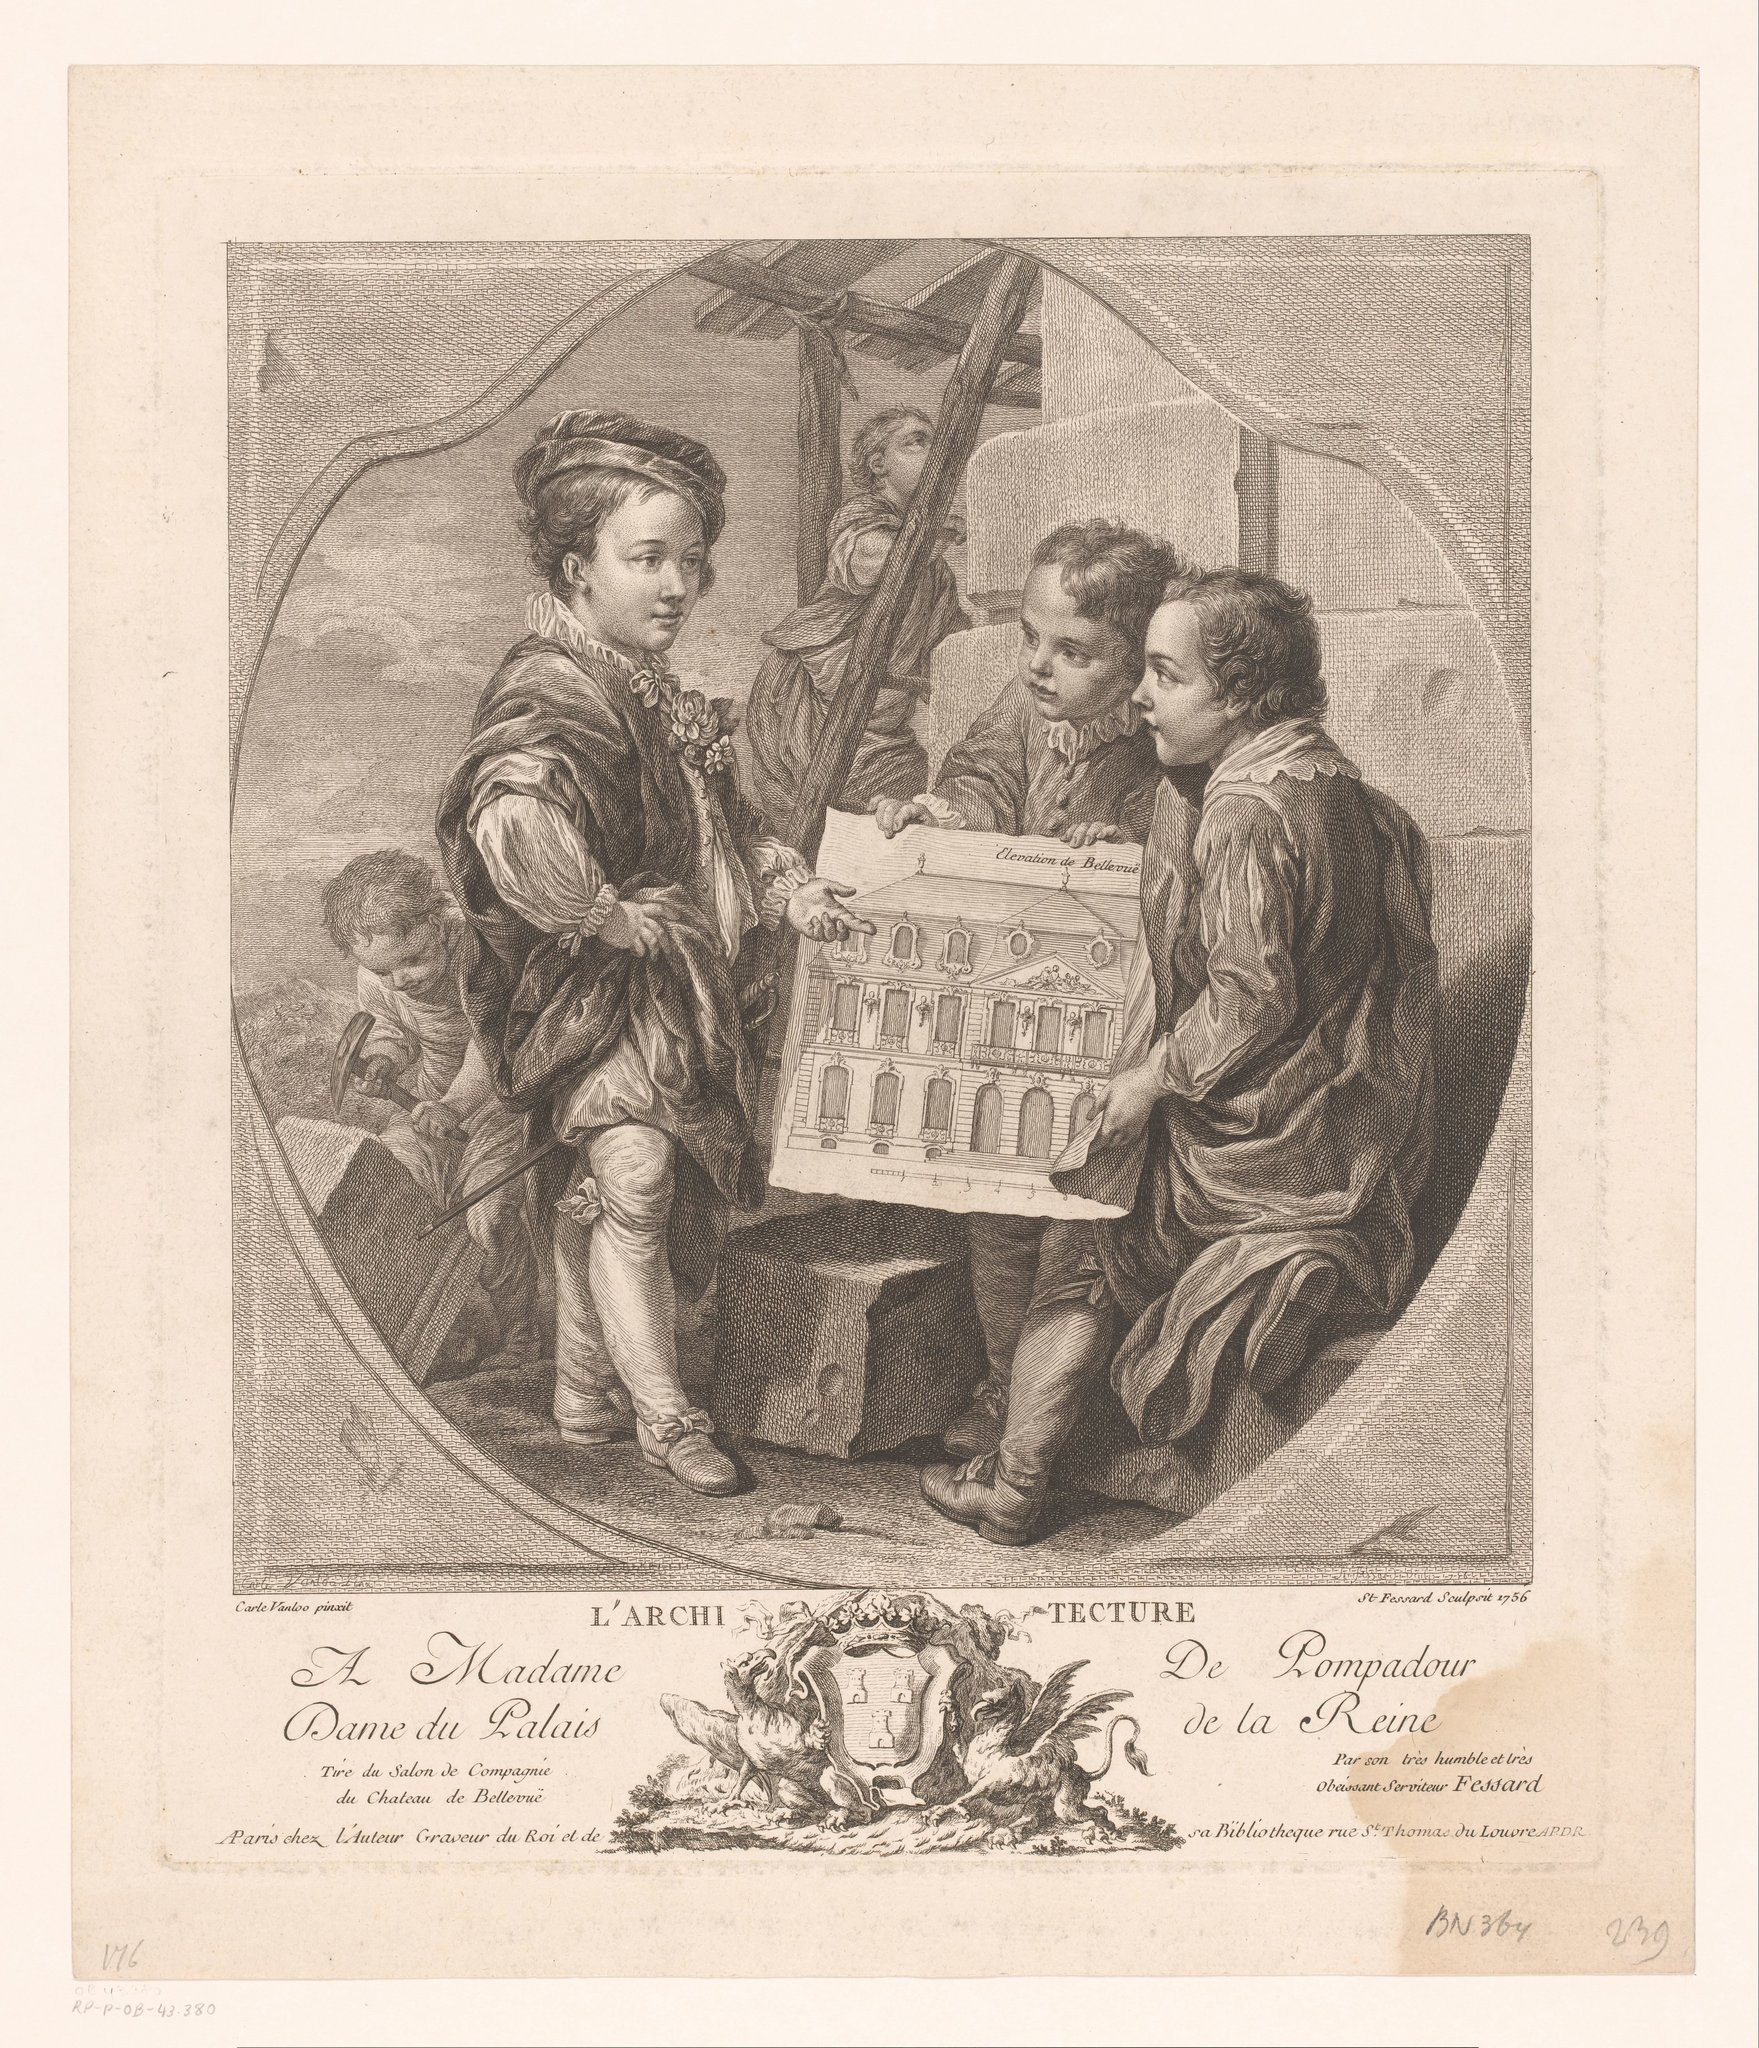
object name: print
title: Personificatie van de architectuur met ontwerpschets voor een villa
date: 1756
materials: paper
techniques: engraving, etching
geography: france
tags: children behaving like adults, architecture, armorial bearing, heraldry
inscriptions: collector's mark: Lugt 2228